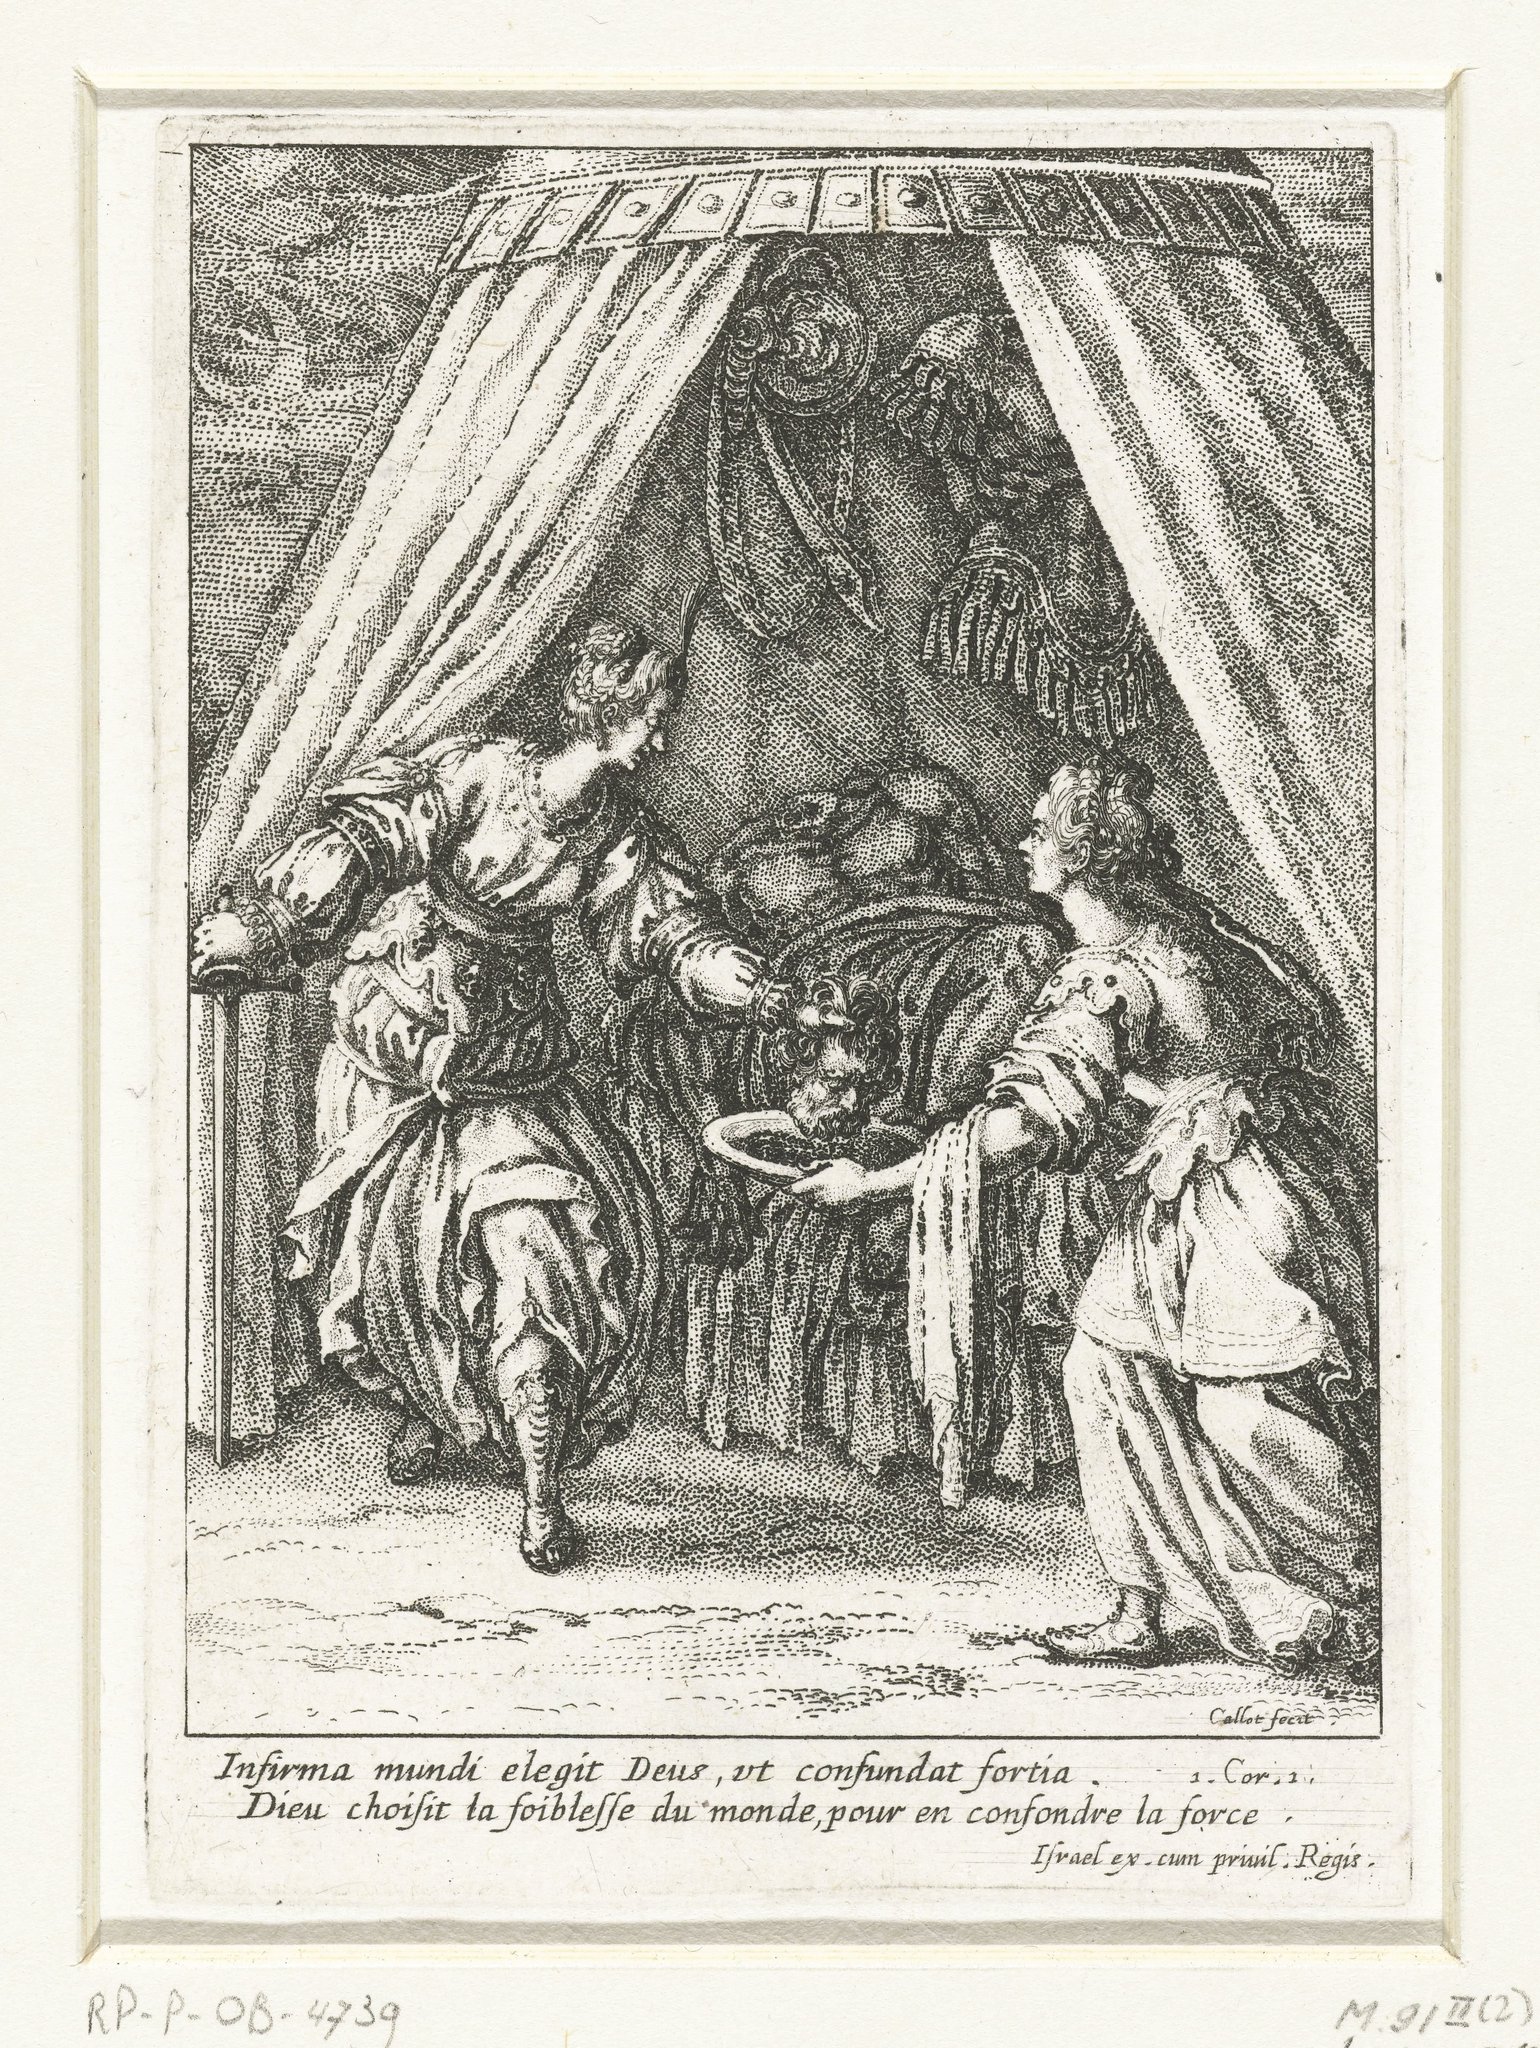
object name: print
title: Judith met het hoofd van Holofernes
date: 1621-1635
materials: paper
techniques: etching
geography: paris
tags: holofernes' head is put on a dish, and covered with a cloth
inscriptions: collector's mark: Lugt 240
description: Judith legt het hoofd van Holofernes, dat ze zojuist met een zwaard afgehakt heeft, op een schaal die haar dienstmaagd voor haar ophoudt. Het ontzielde lichaam van Holofernes ligt achter haar in bed in een legertent. Onder de voorstelling een onderschrift in Latijn.